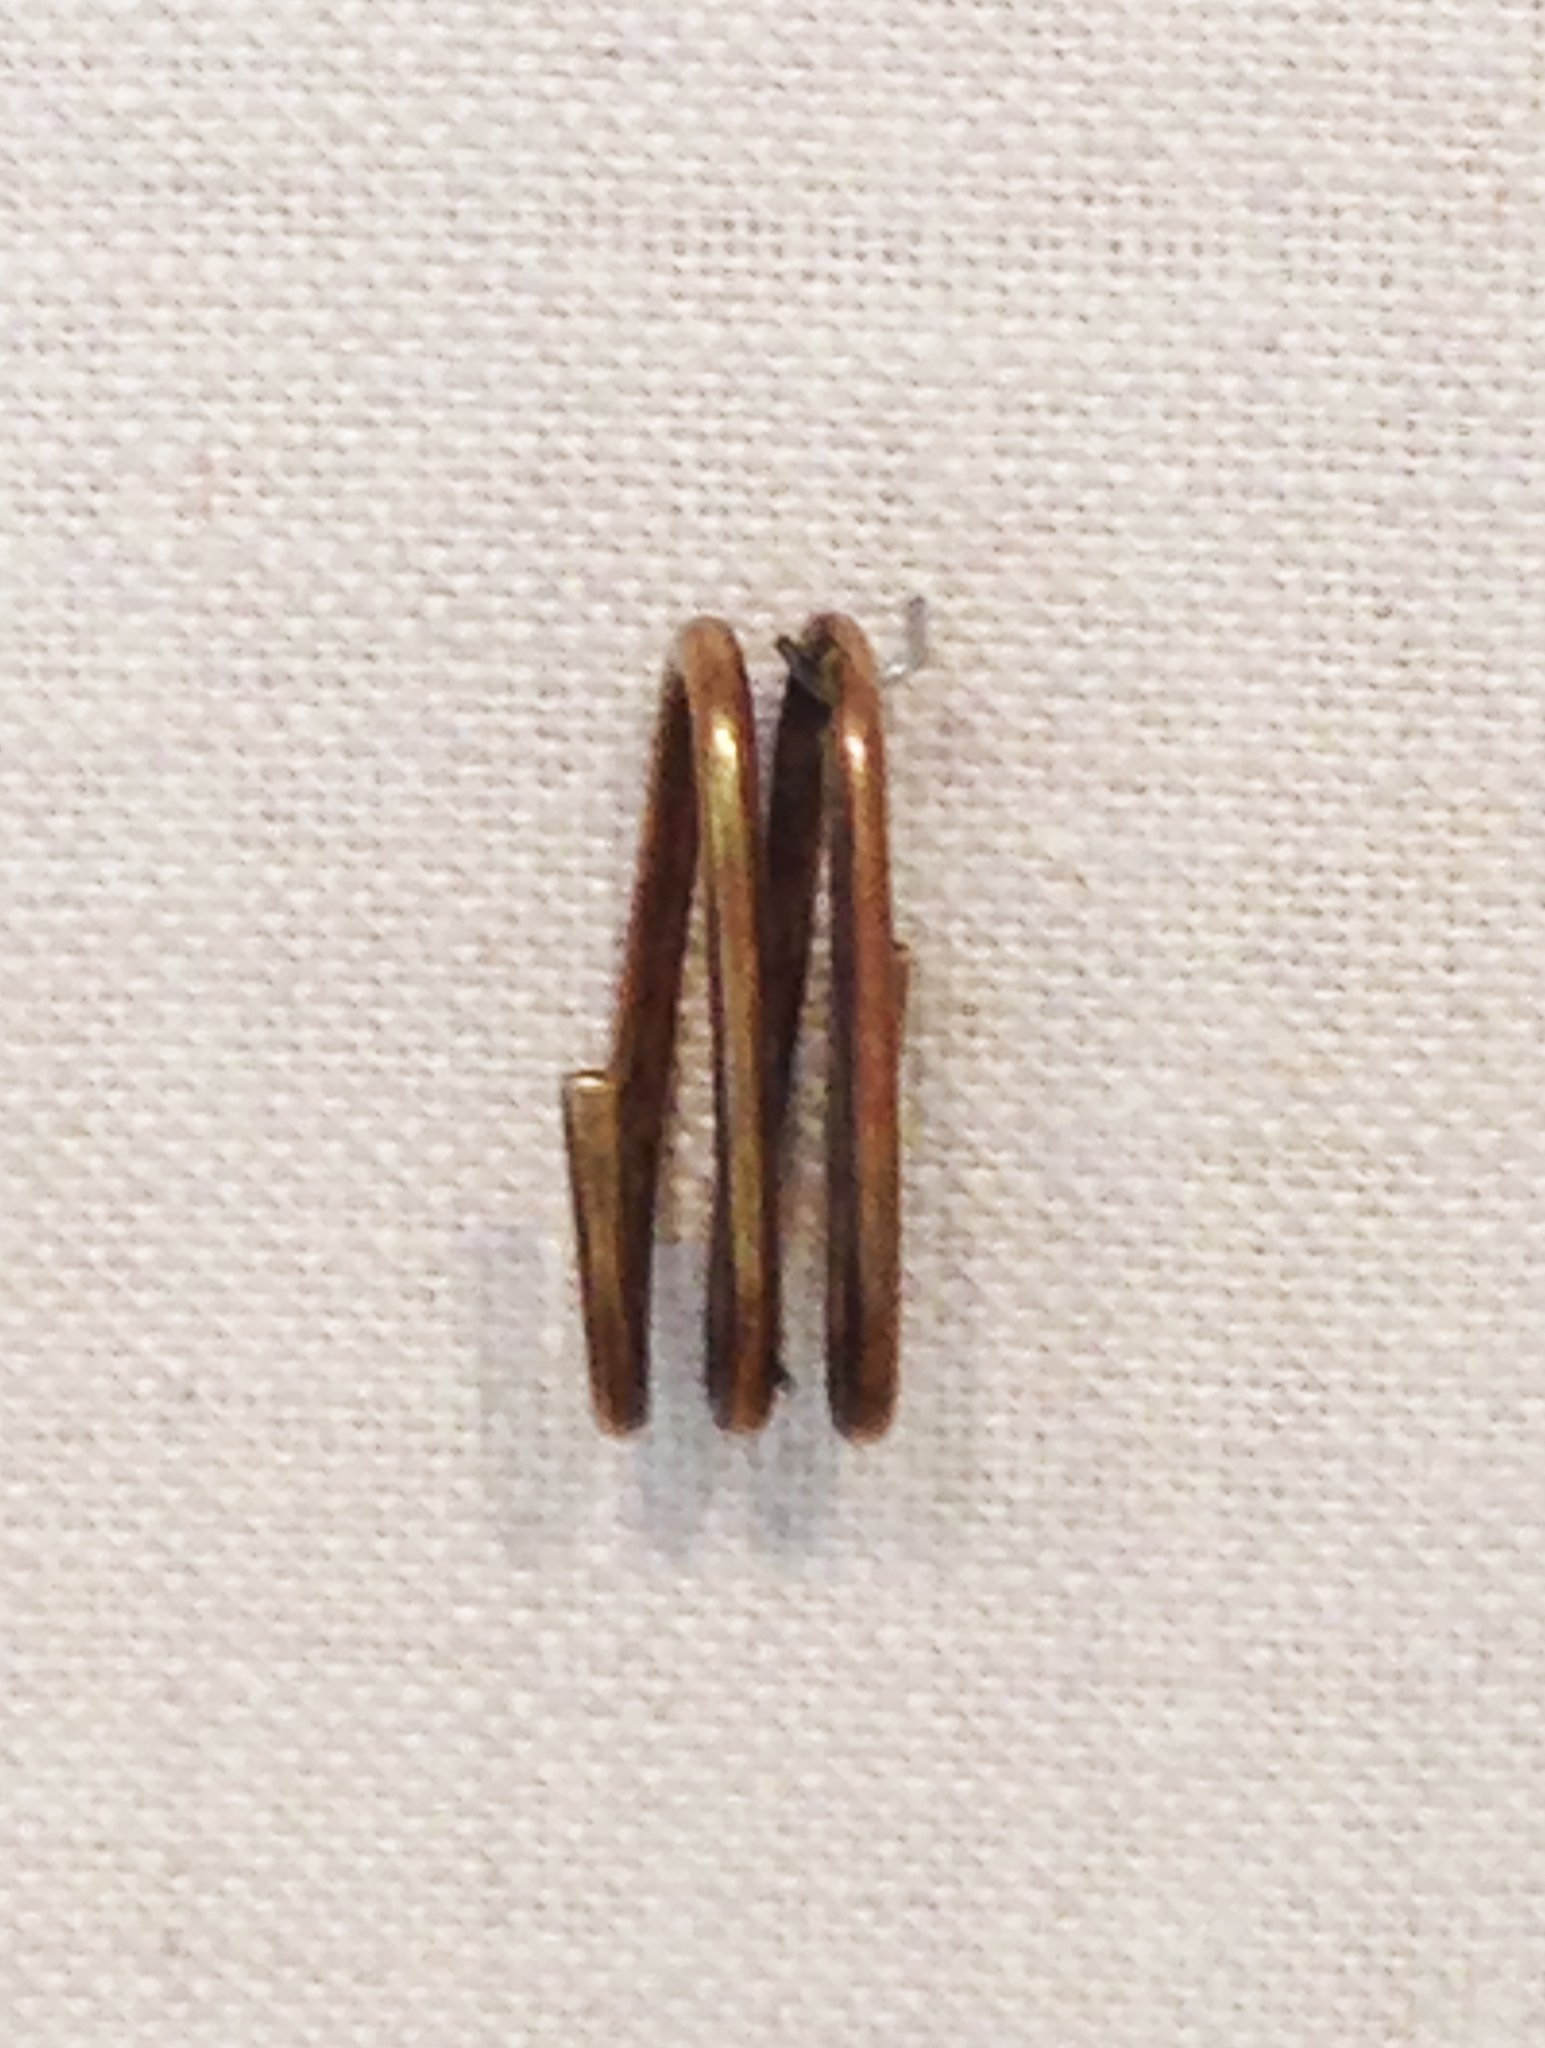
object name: earring or spiral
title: Gold spiral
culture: cypriot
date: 1600-1100 BCE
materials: gold